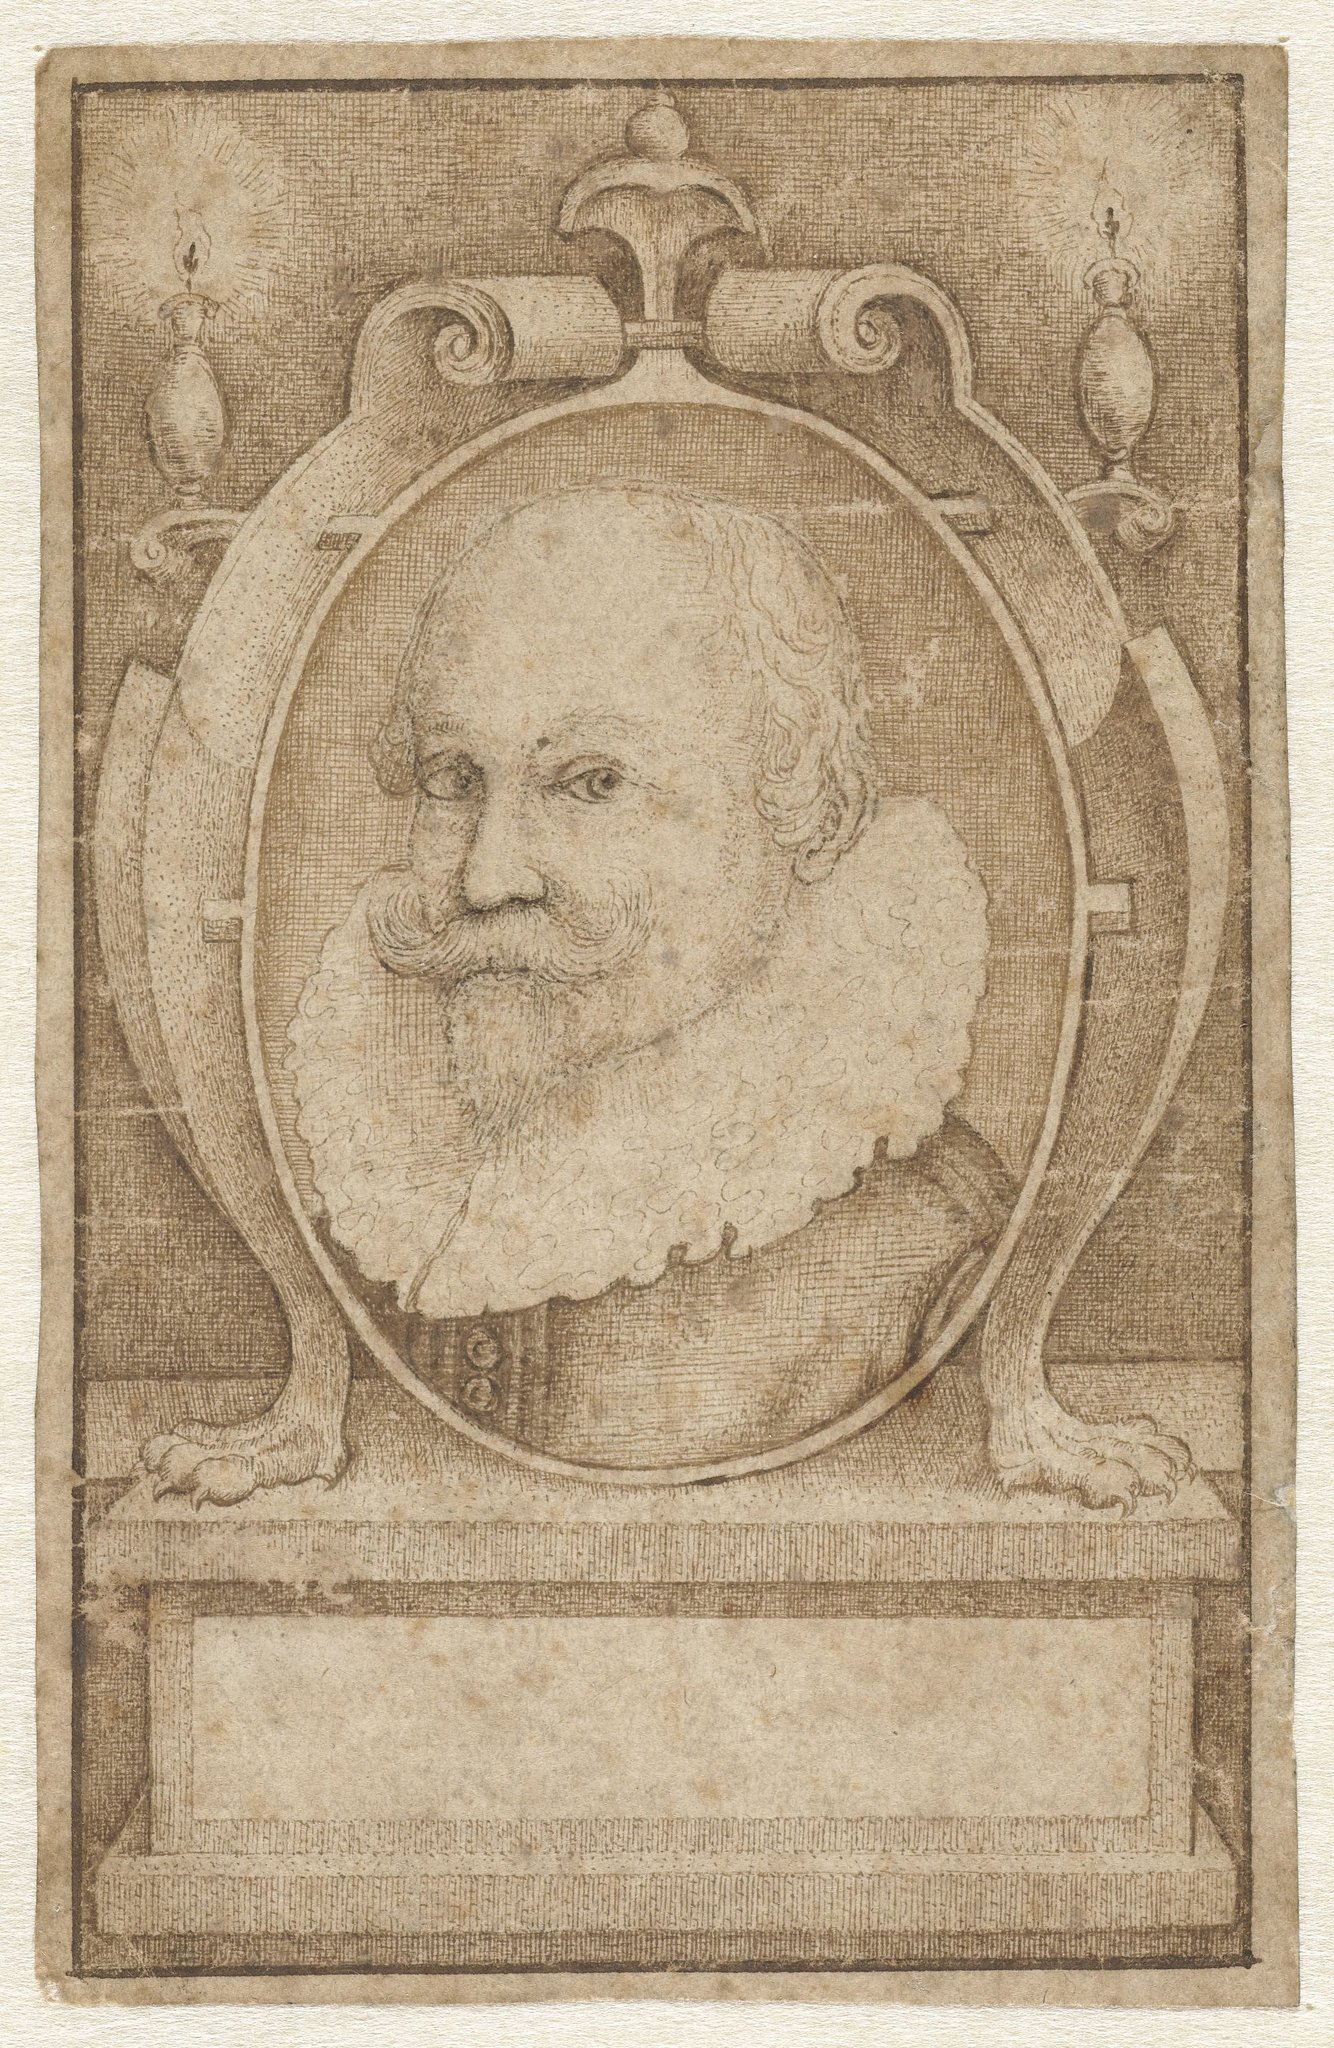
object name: drawing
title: Portret van een man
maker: monogrammist ws (graveur)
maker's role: print maker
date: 1614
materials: ink, paper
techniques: pen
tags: anonymous historical person portrayed alone